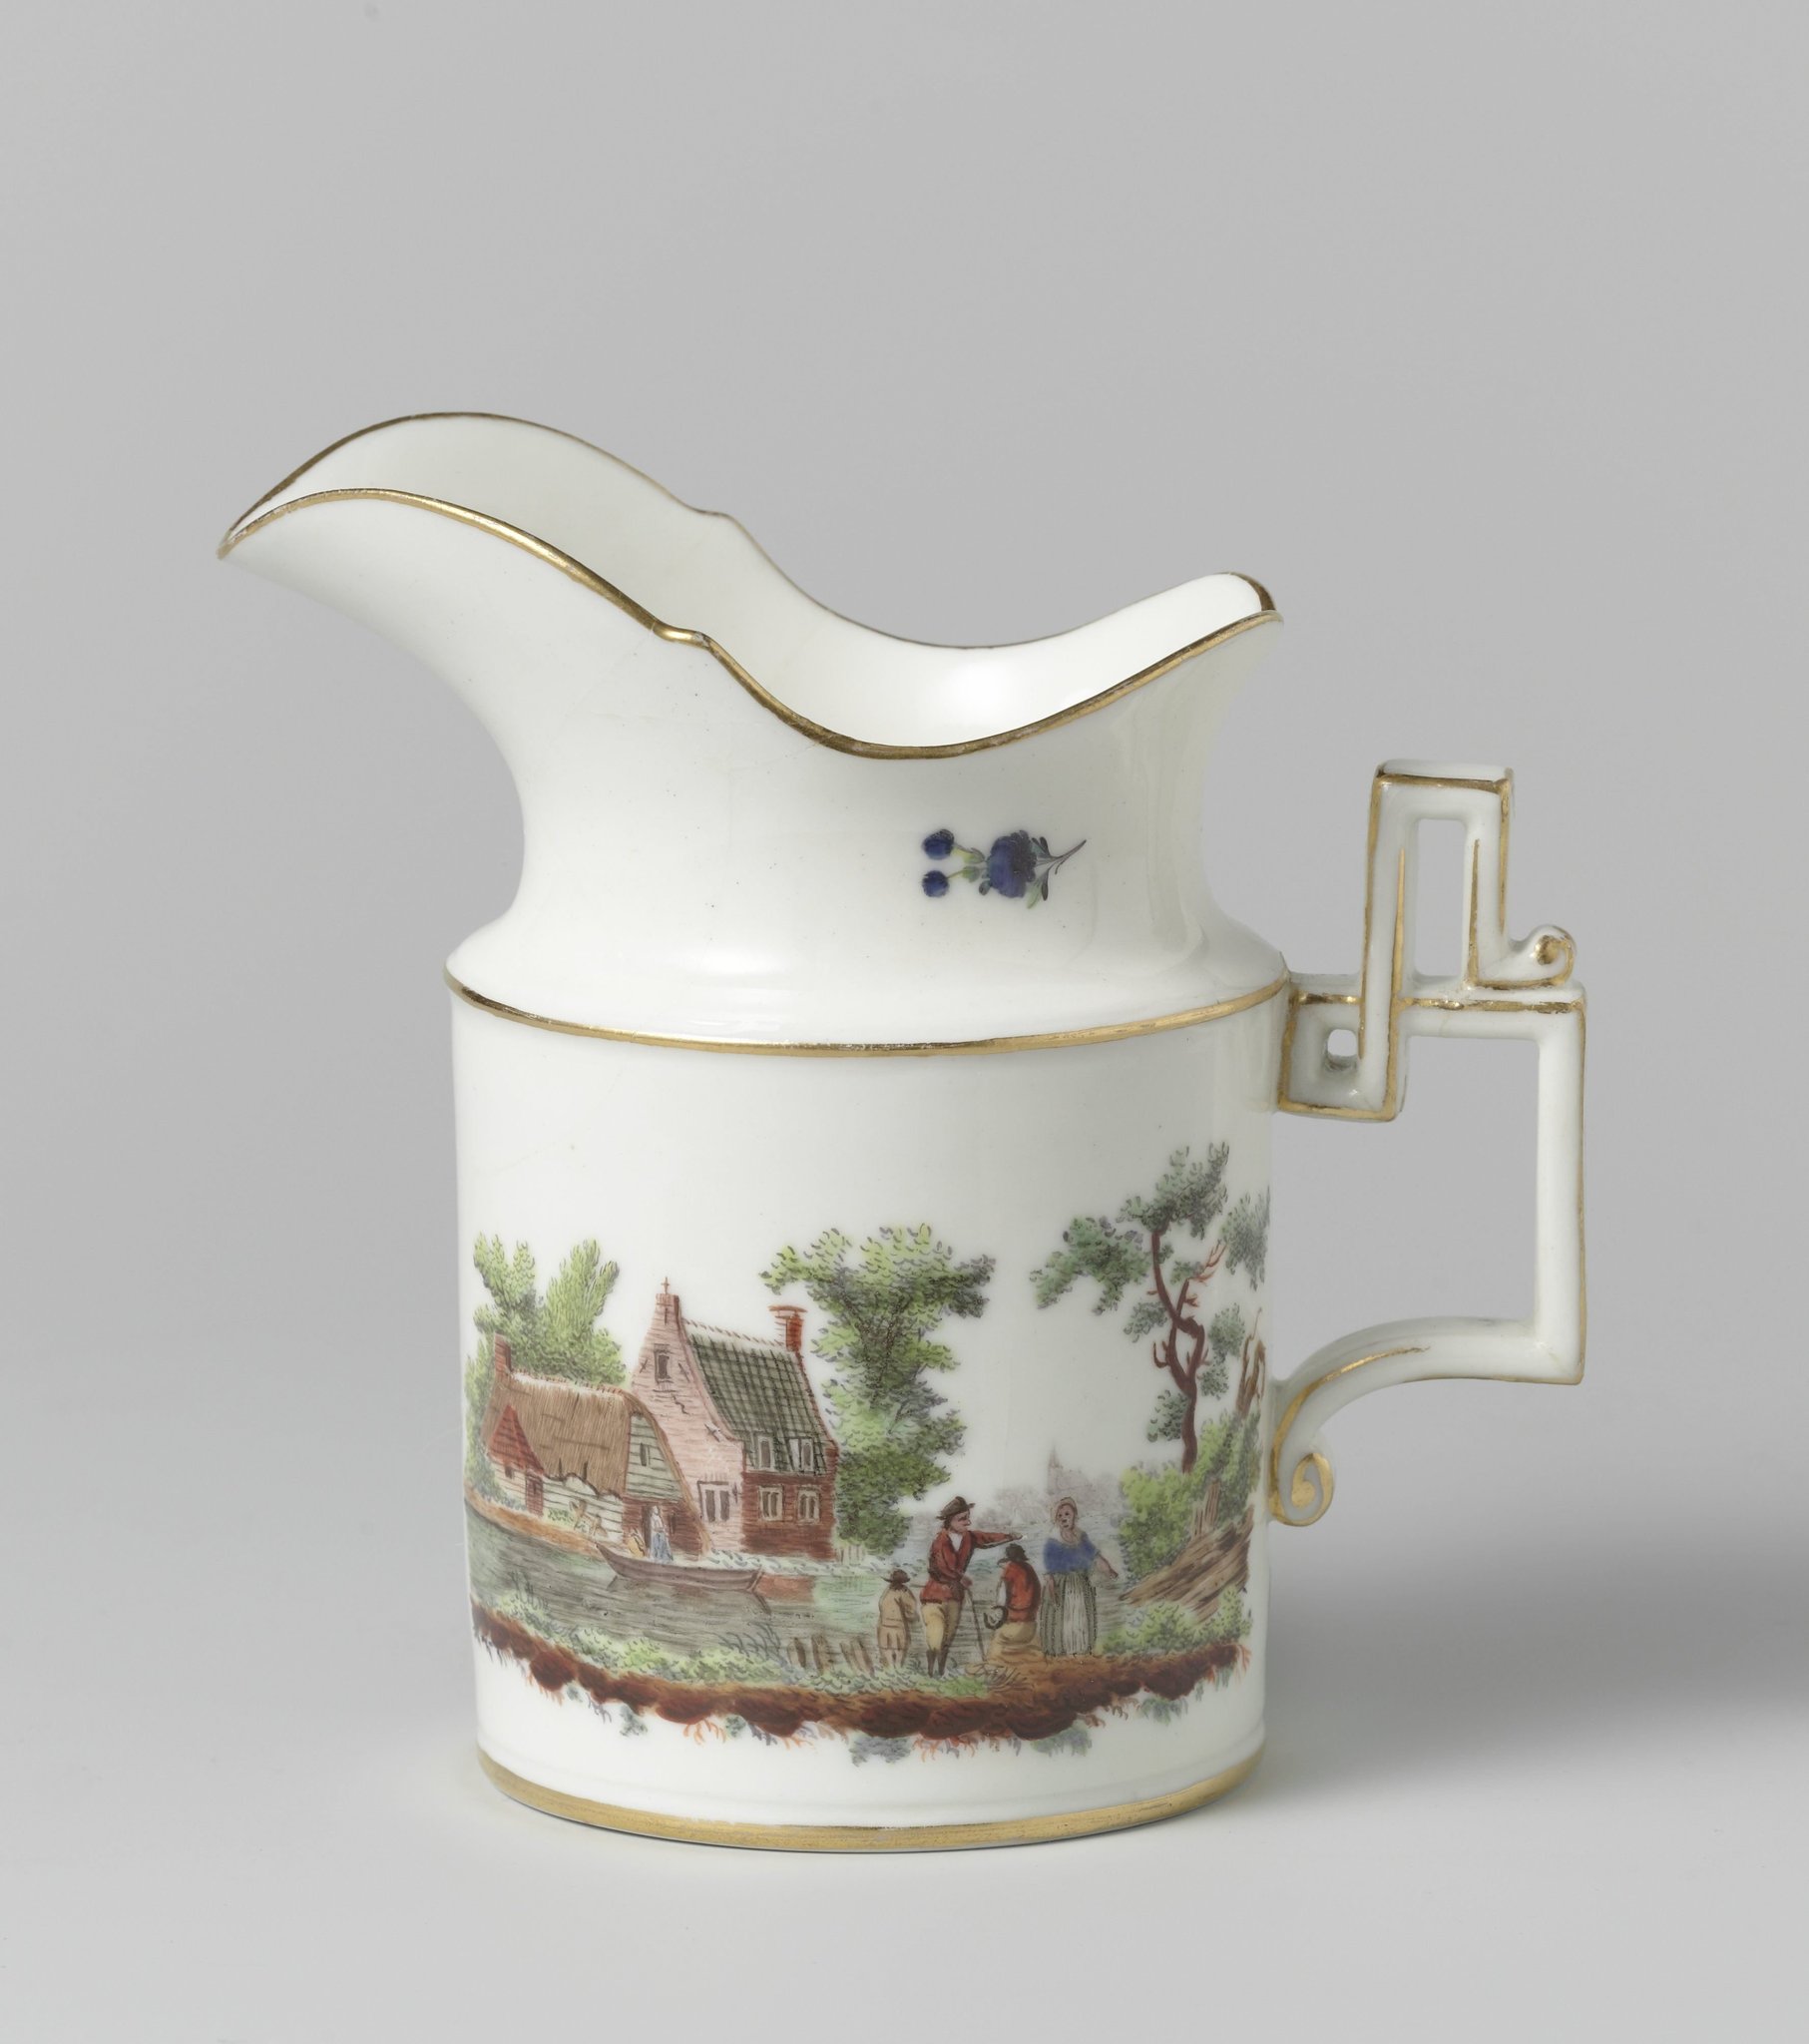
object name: milk jug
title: Teapot and milk jug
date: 1800-1805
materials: porcelain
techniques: painted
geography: ouder-amstel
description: Porseleinfabriek Dommer & Co. Ouder-Amstel, c. 1800–1805 hard-paste porcelain